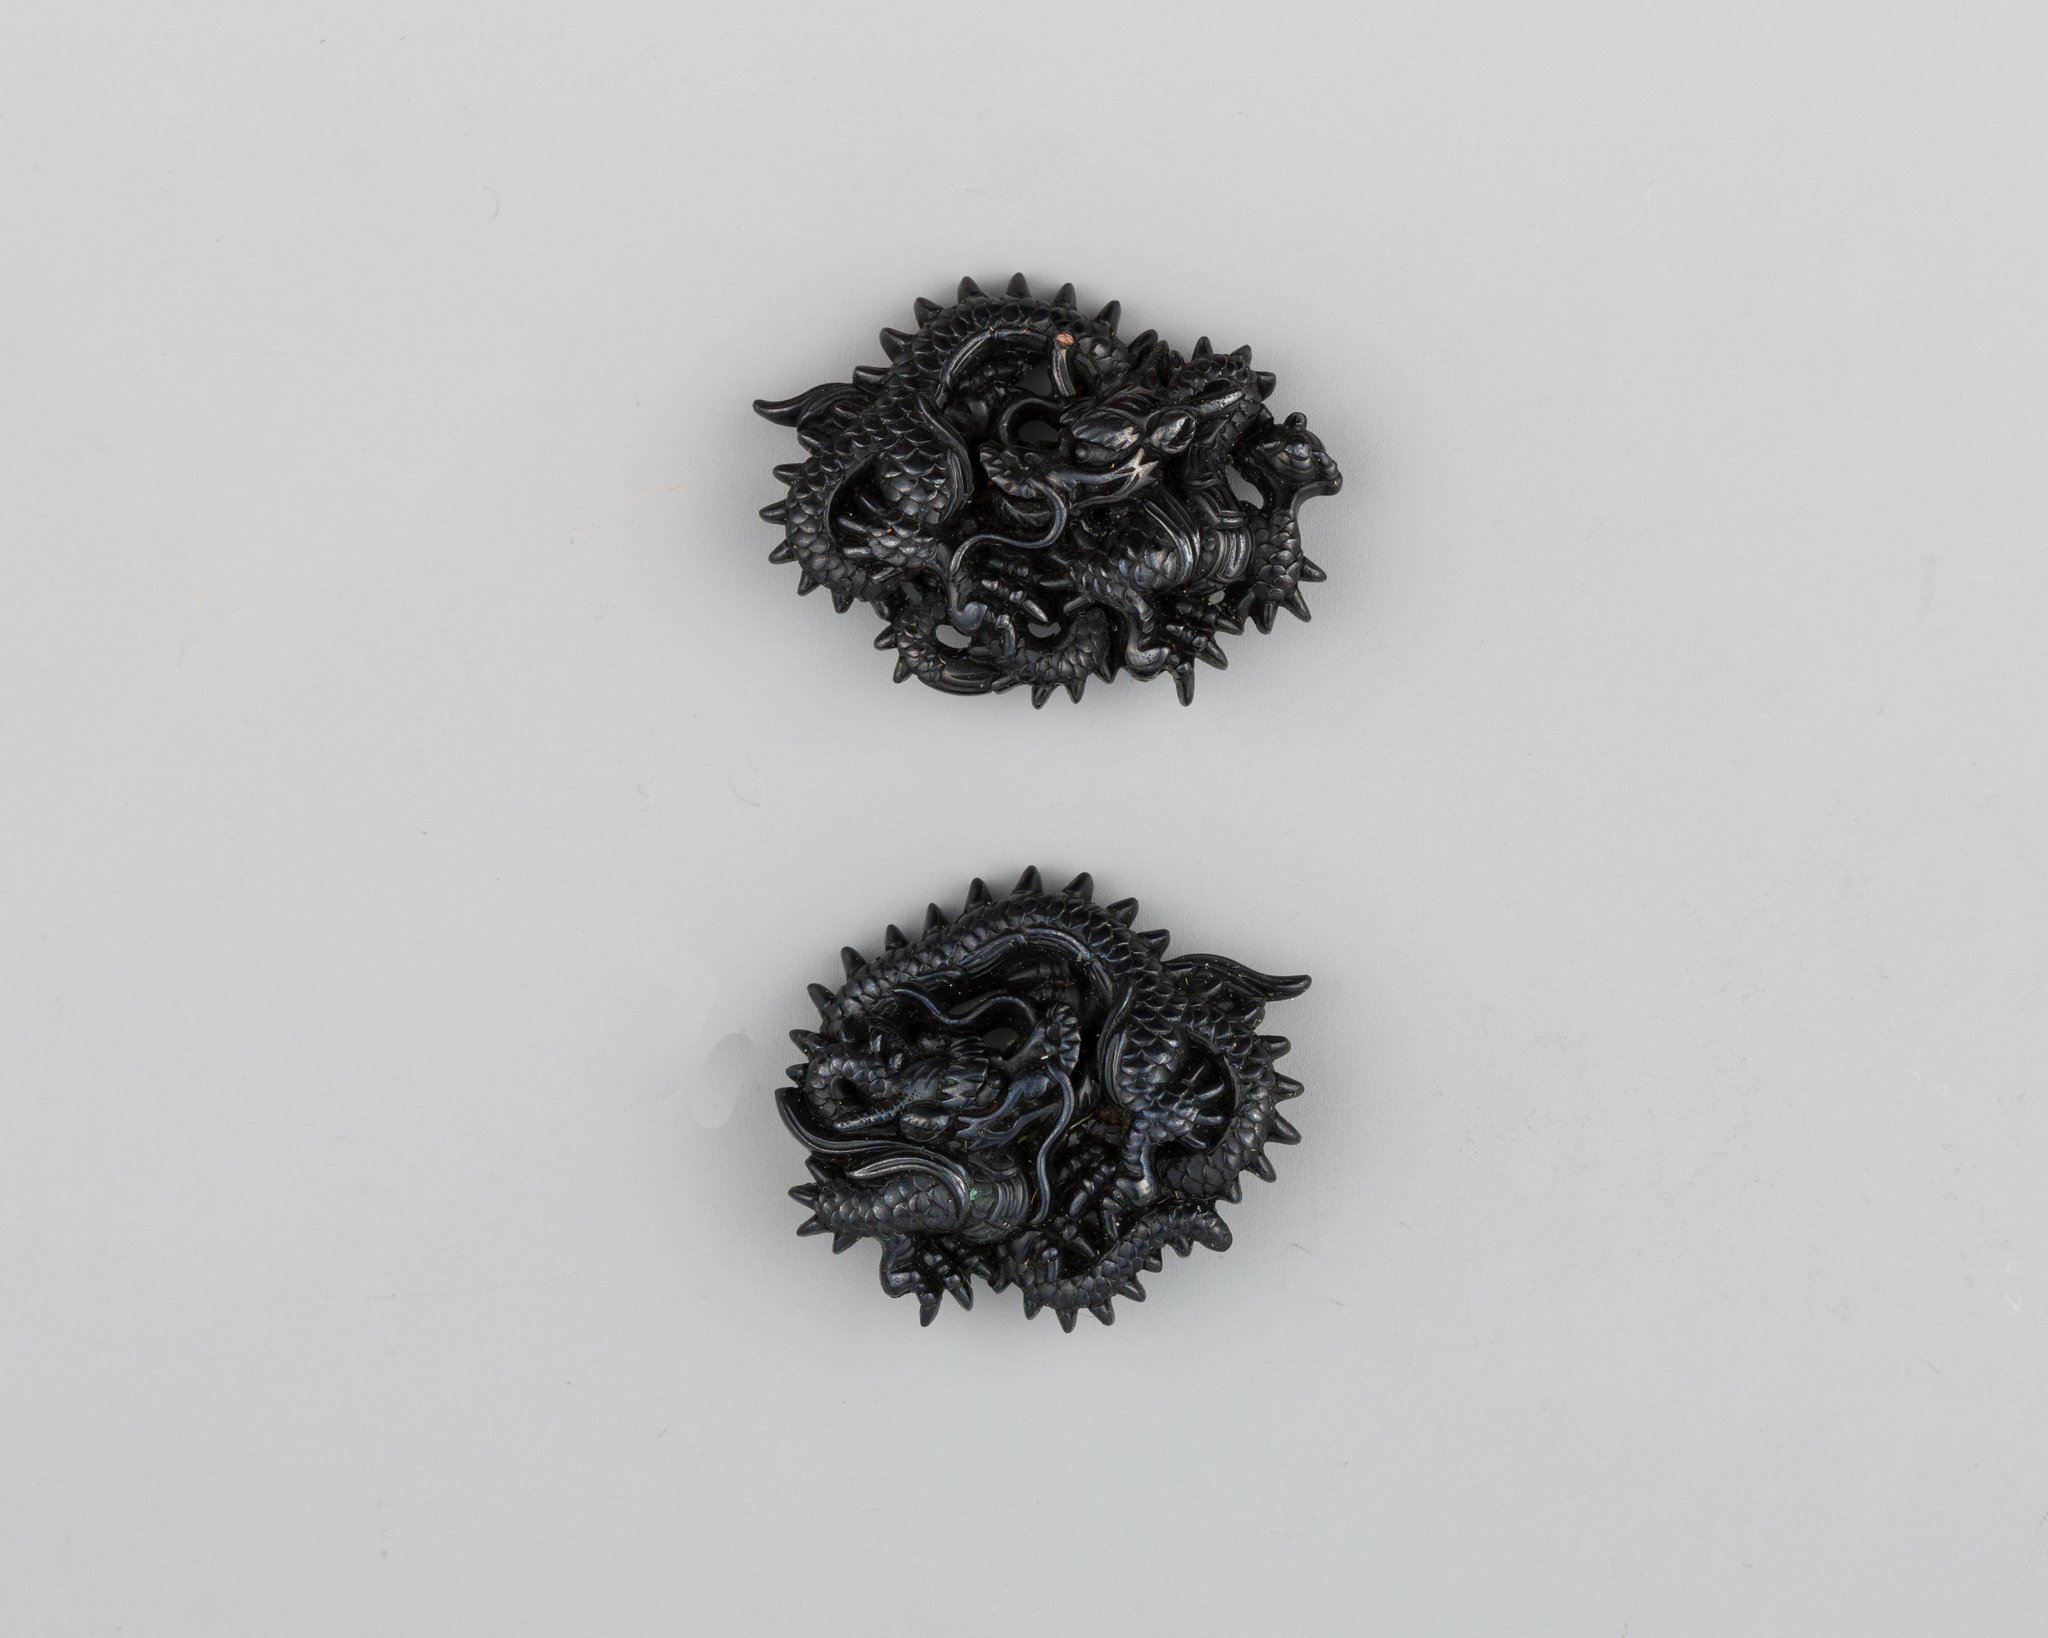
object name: pair of sword grip ornament menuki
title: Pair of Sword-Grip Ornaments (Menuki)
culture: japanese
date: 1801-1900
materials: gold alloy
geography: japan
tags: dragons